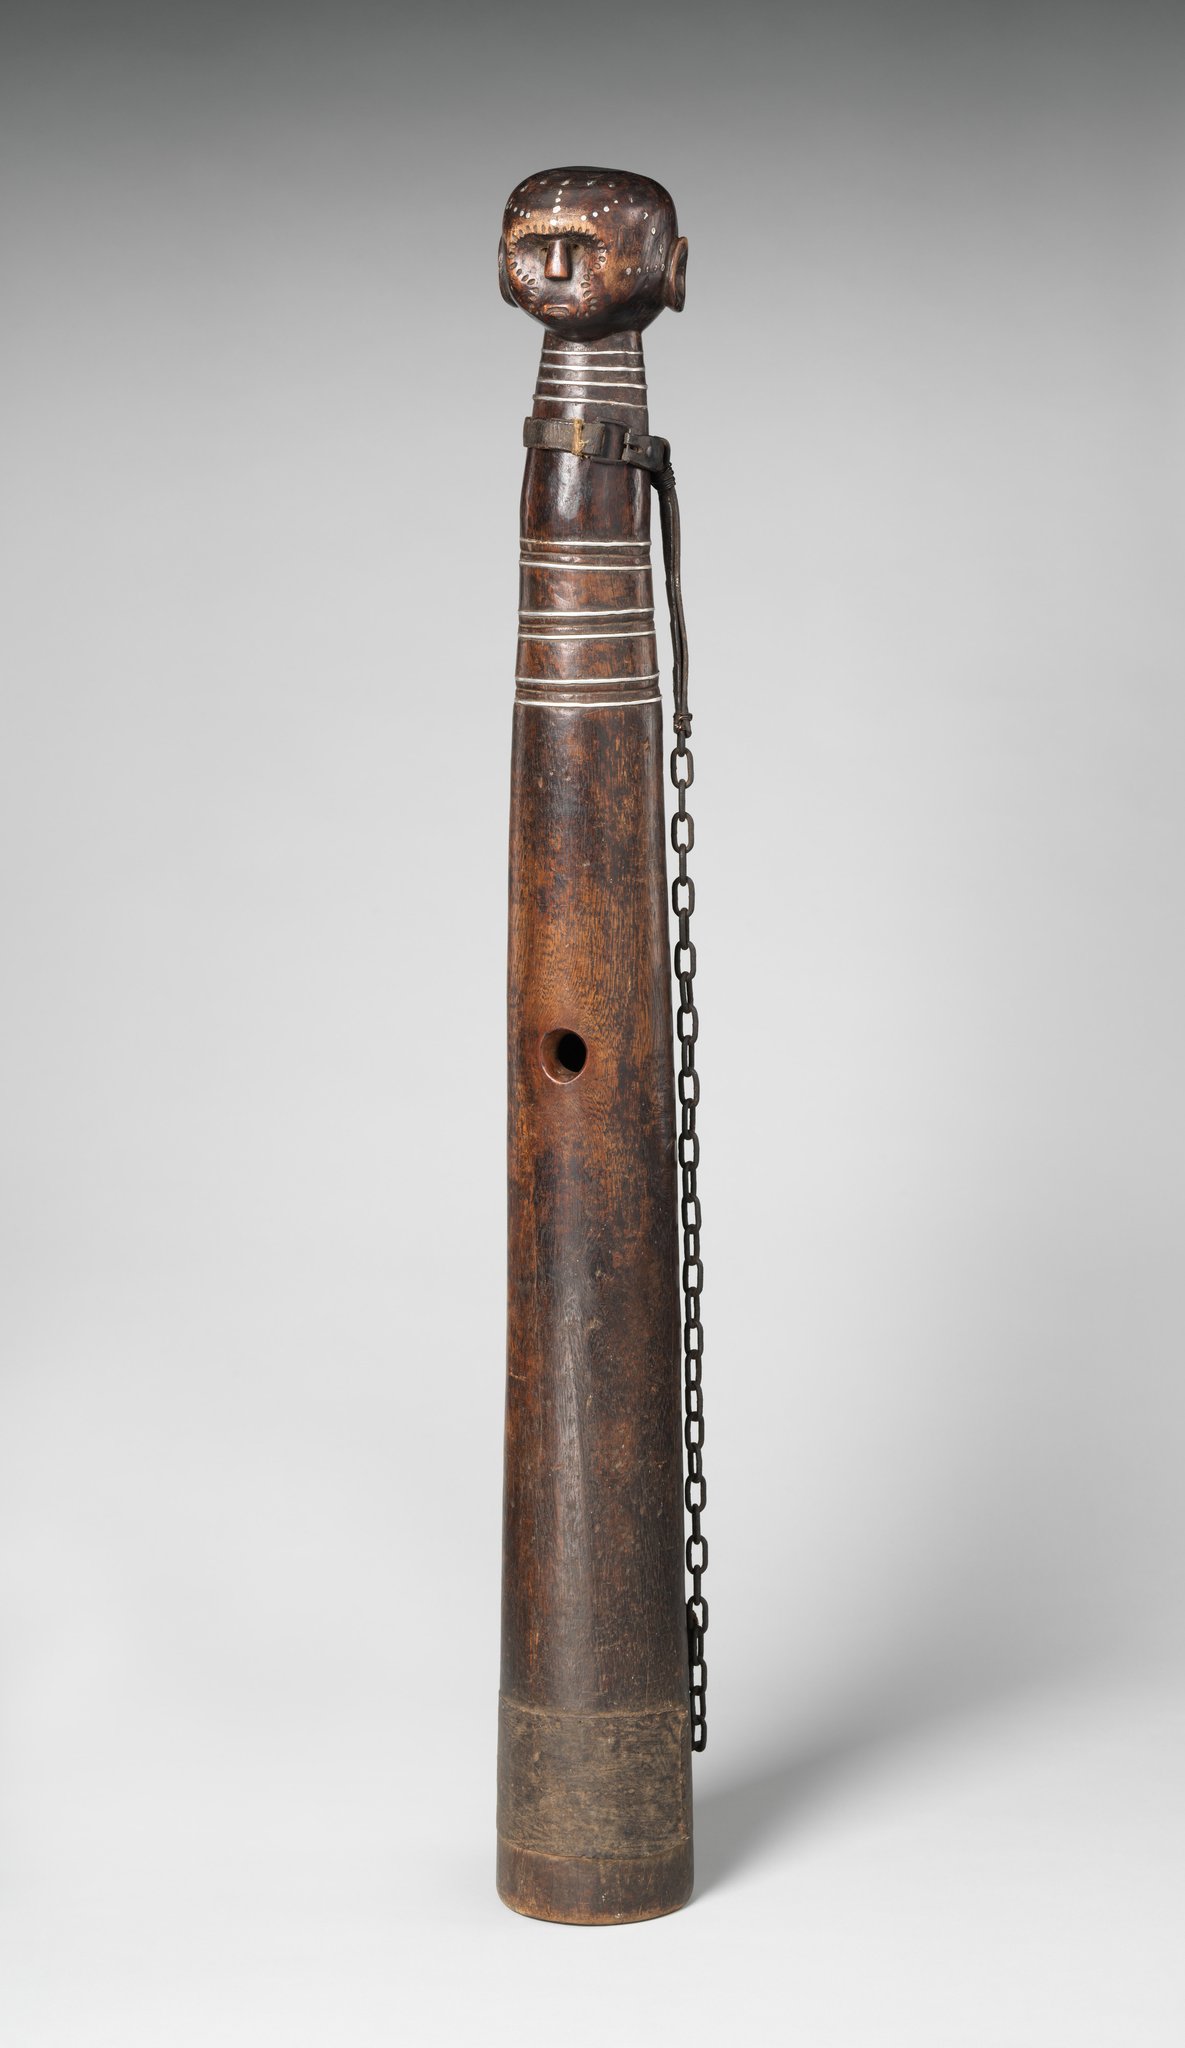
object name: megaphone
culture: tanzanian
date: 1850-1900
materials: leather, metal, wood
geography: tanzania